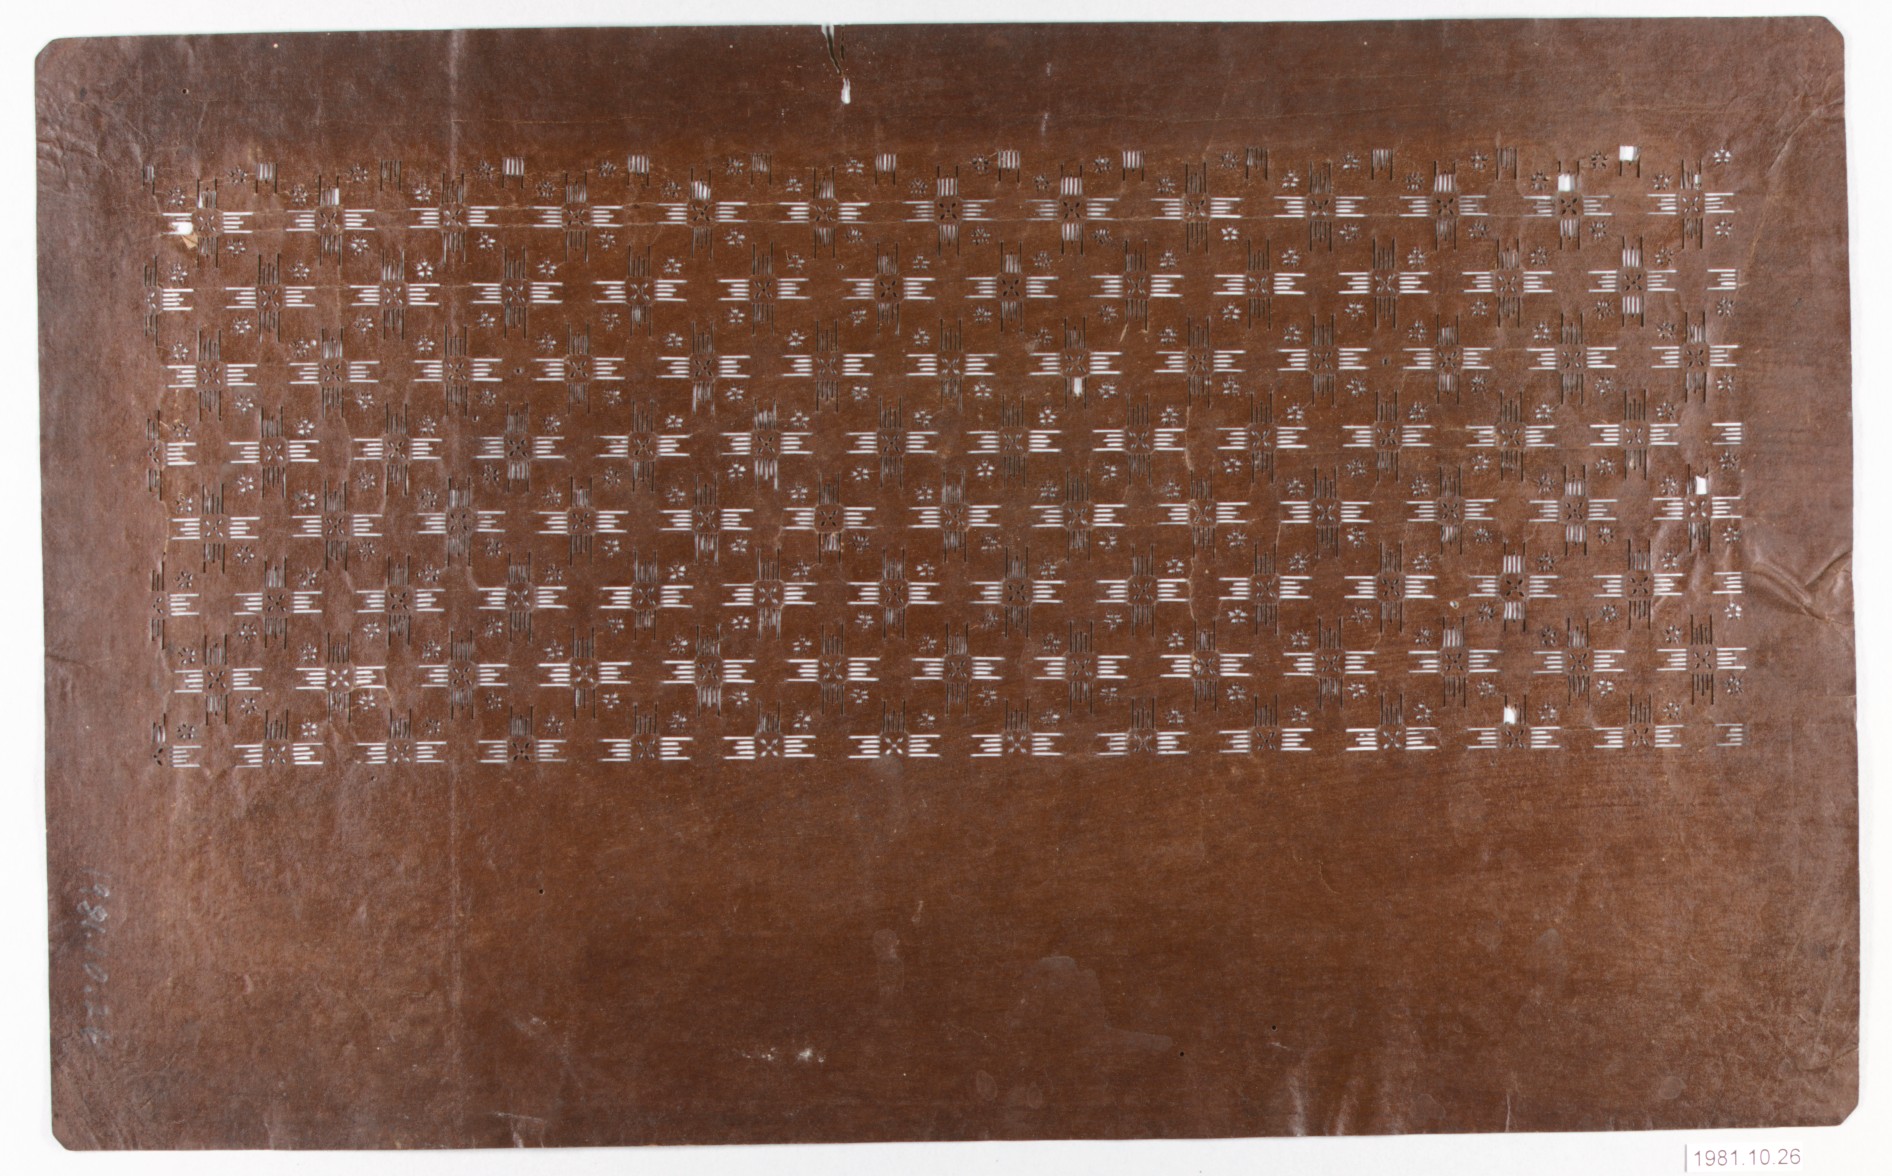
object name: stencil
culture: japanese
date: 1801-1900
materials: paper